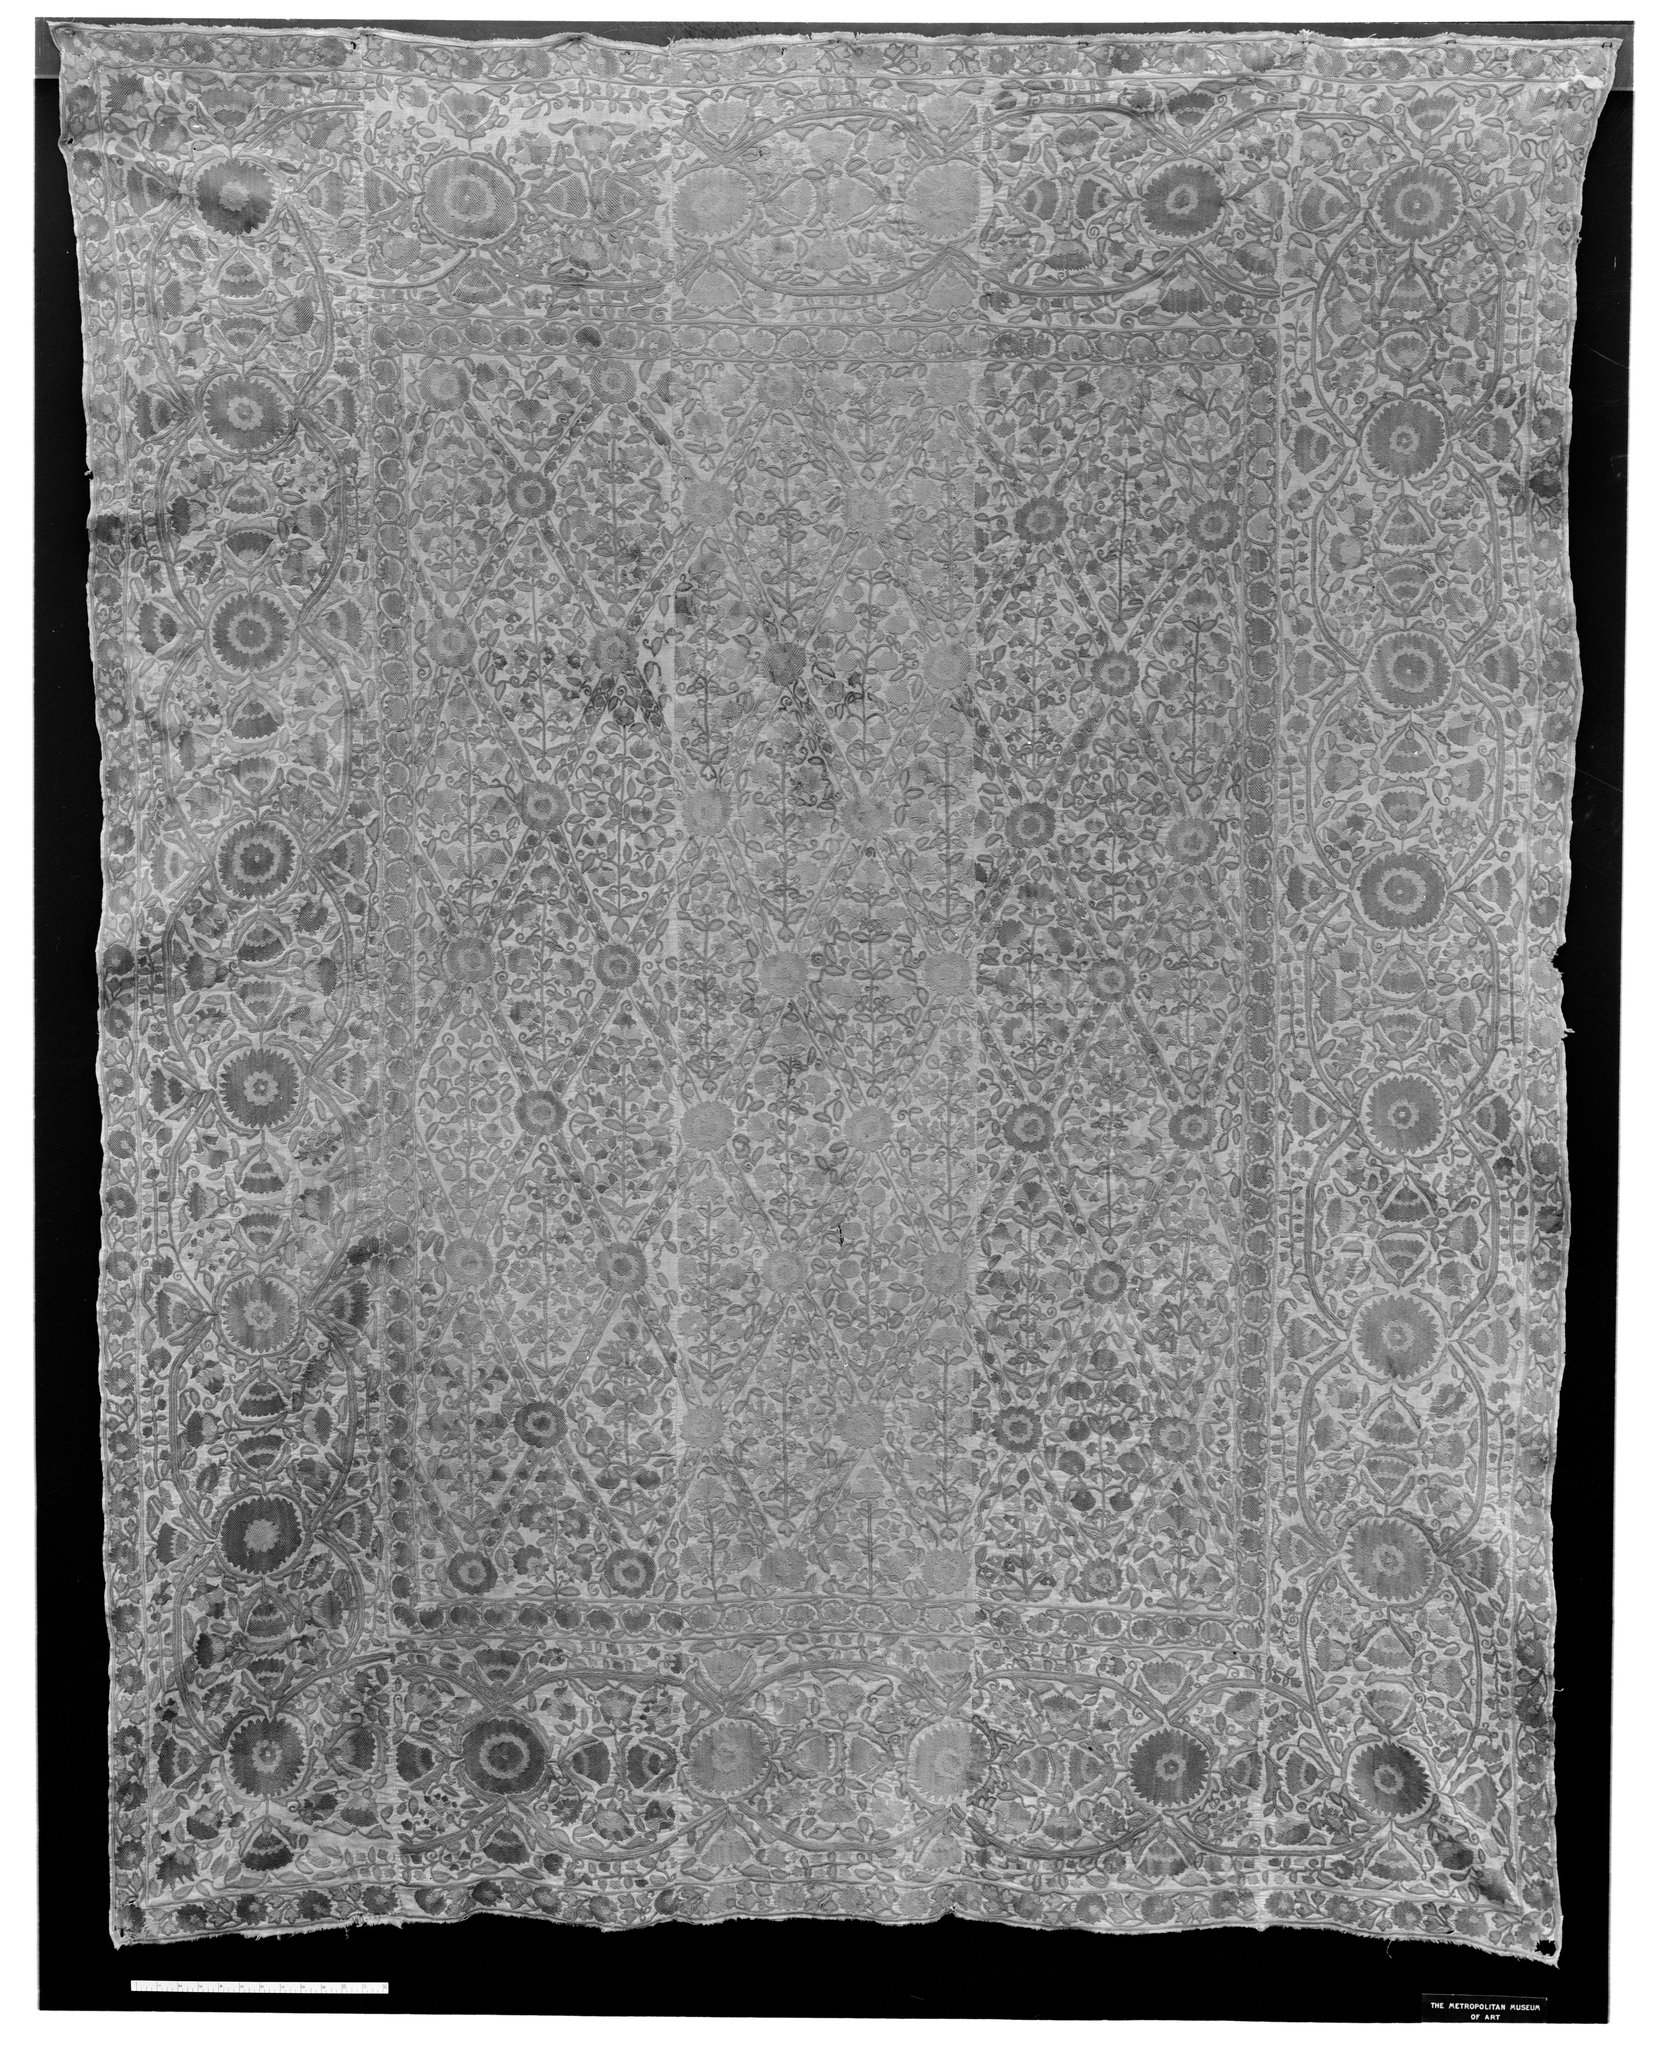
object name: hanging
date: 1701-1800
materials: cotton, silk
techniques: embroidery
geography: uzbekistan